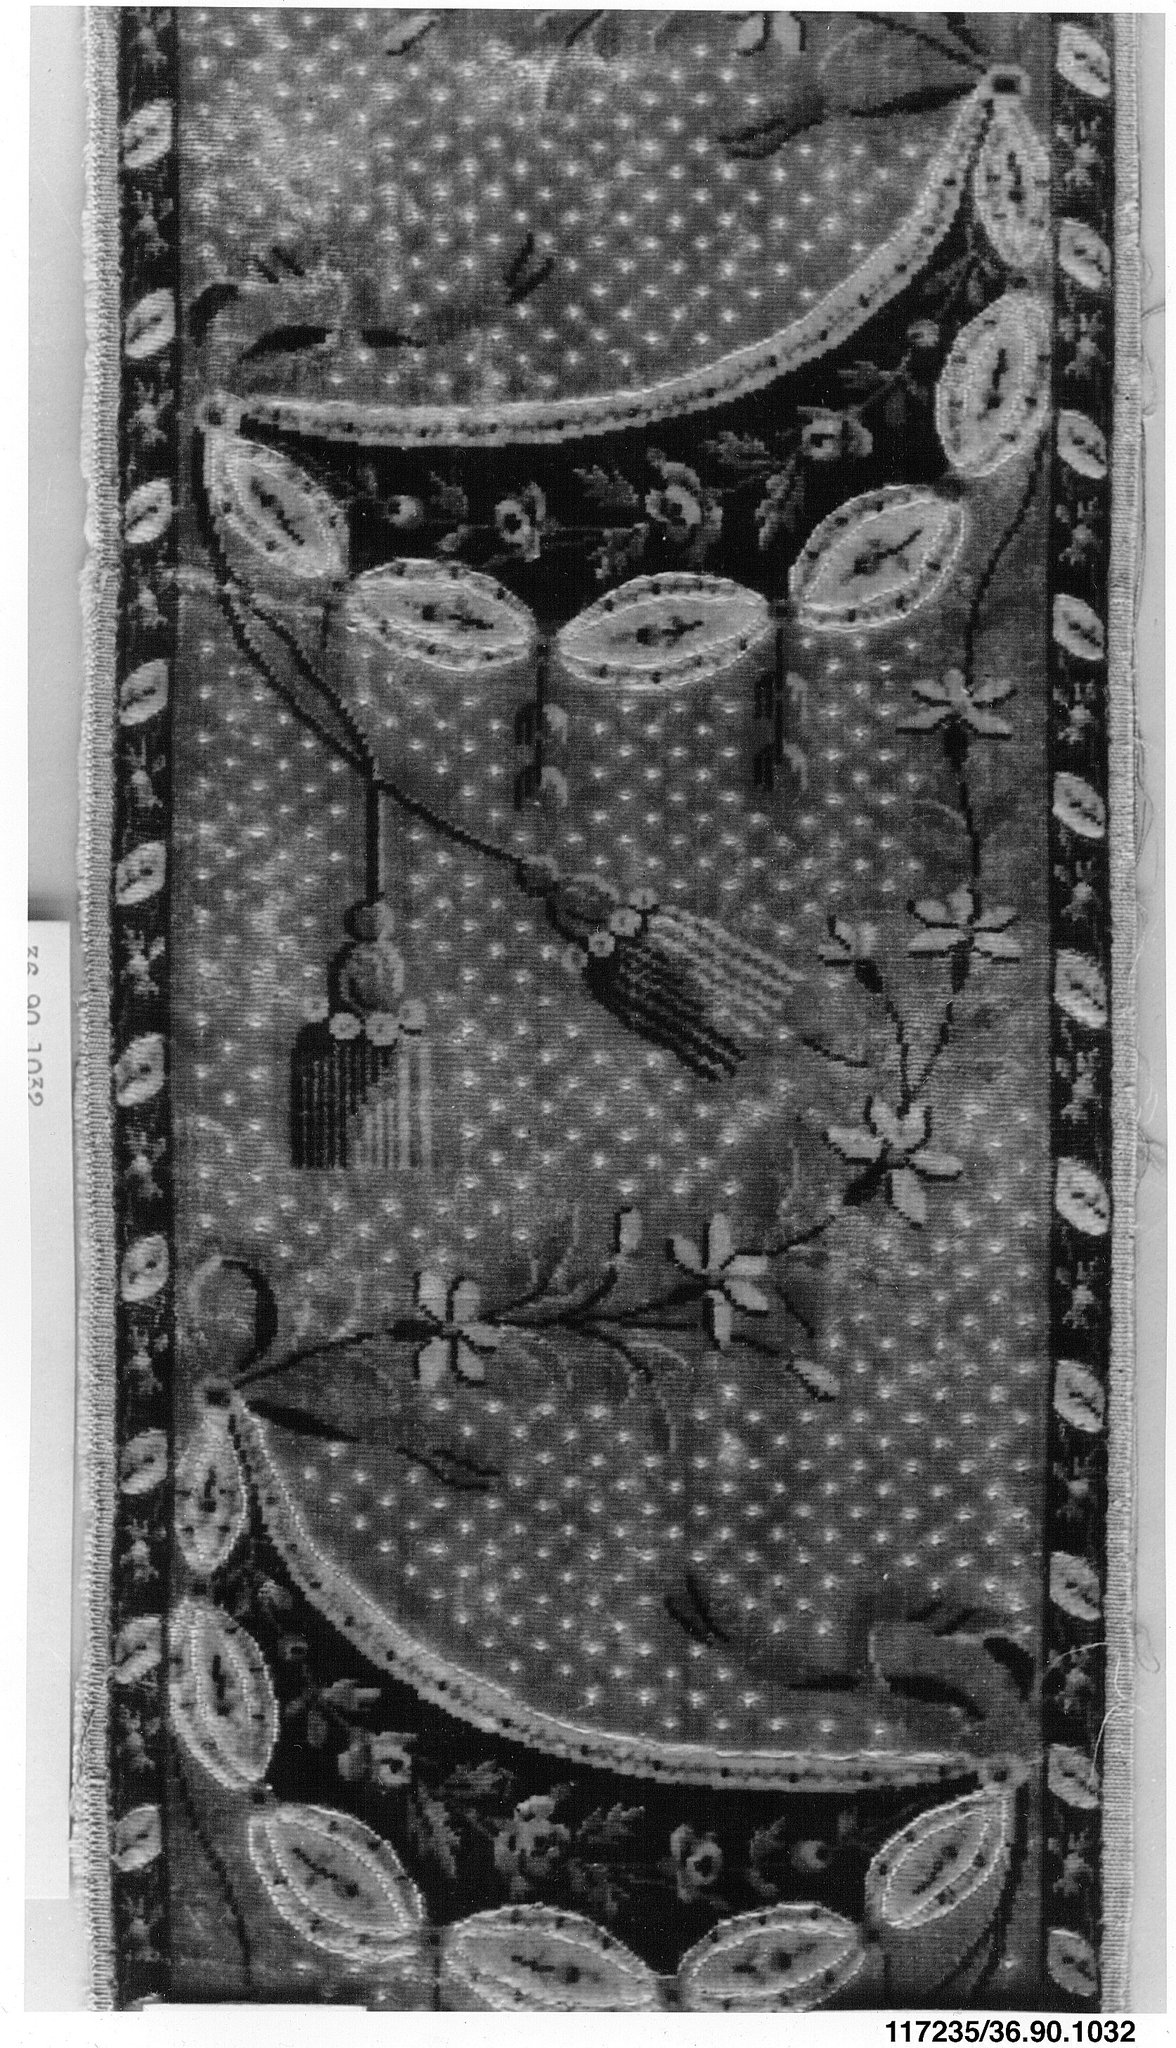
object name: piece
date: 1801-1900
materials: silk